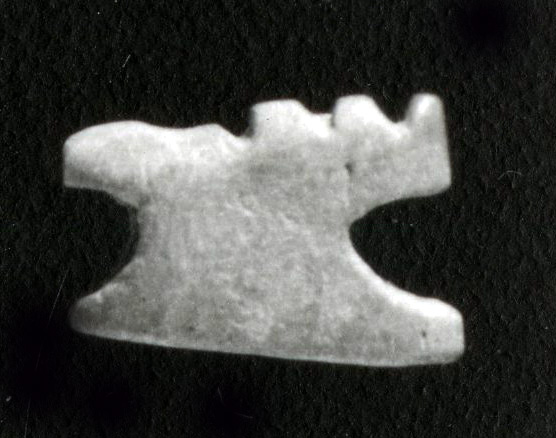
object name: amulet, lion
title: Lion amulet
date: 2110-2030 BCE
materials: ivory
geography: egypt